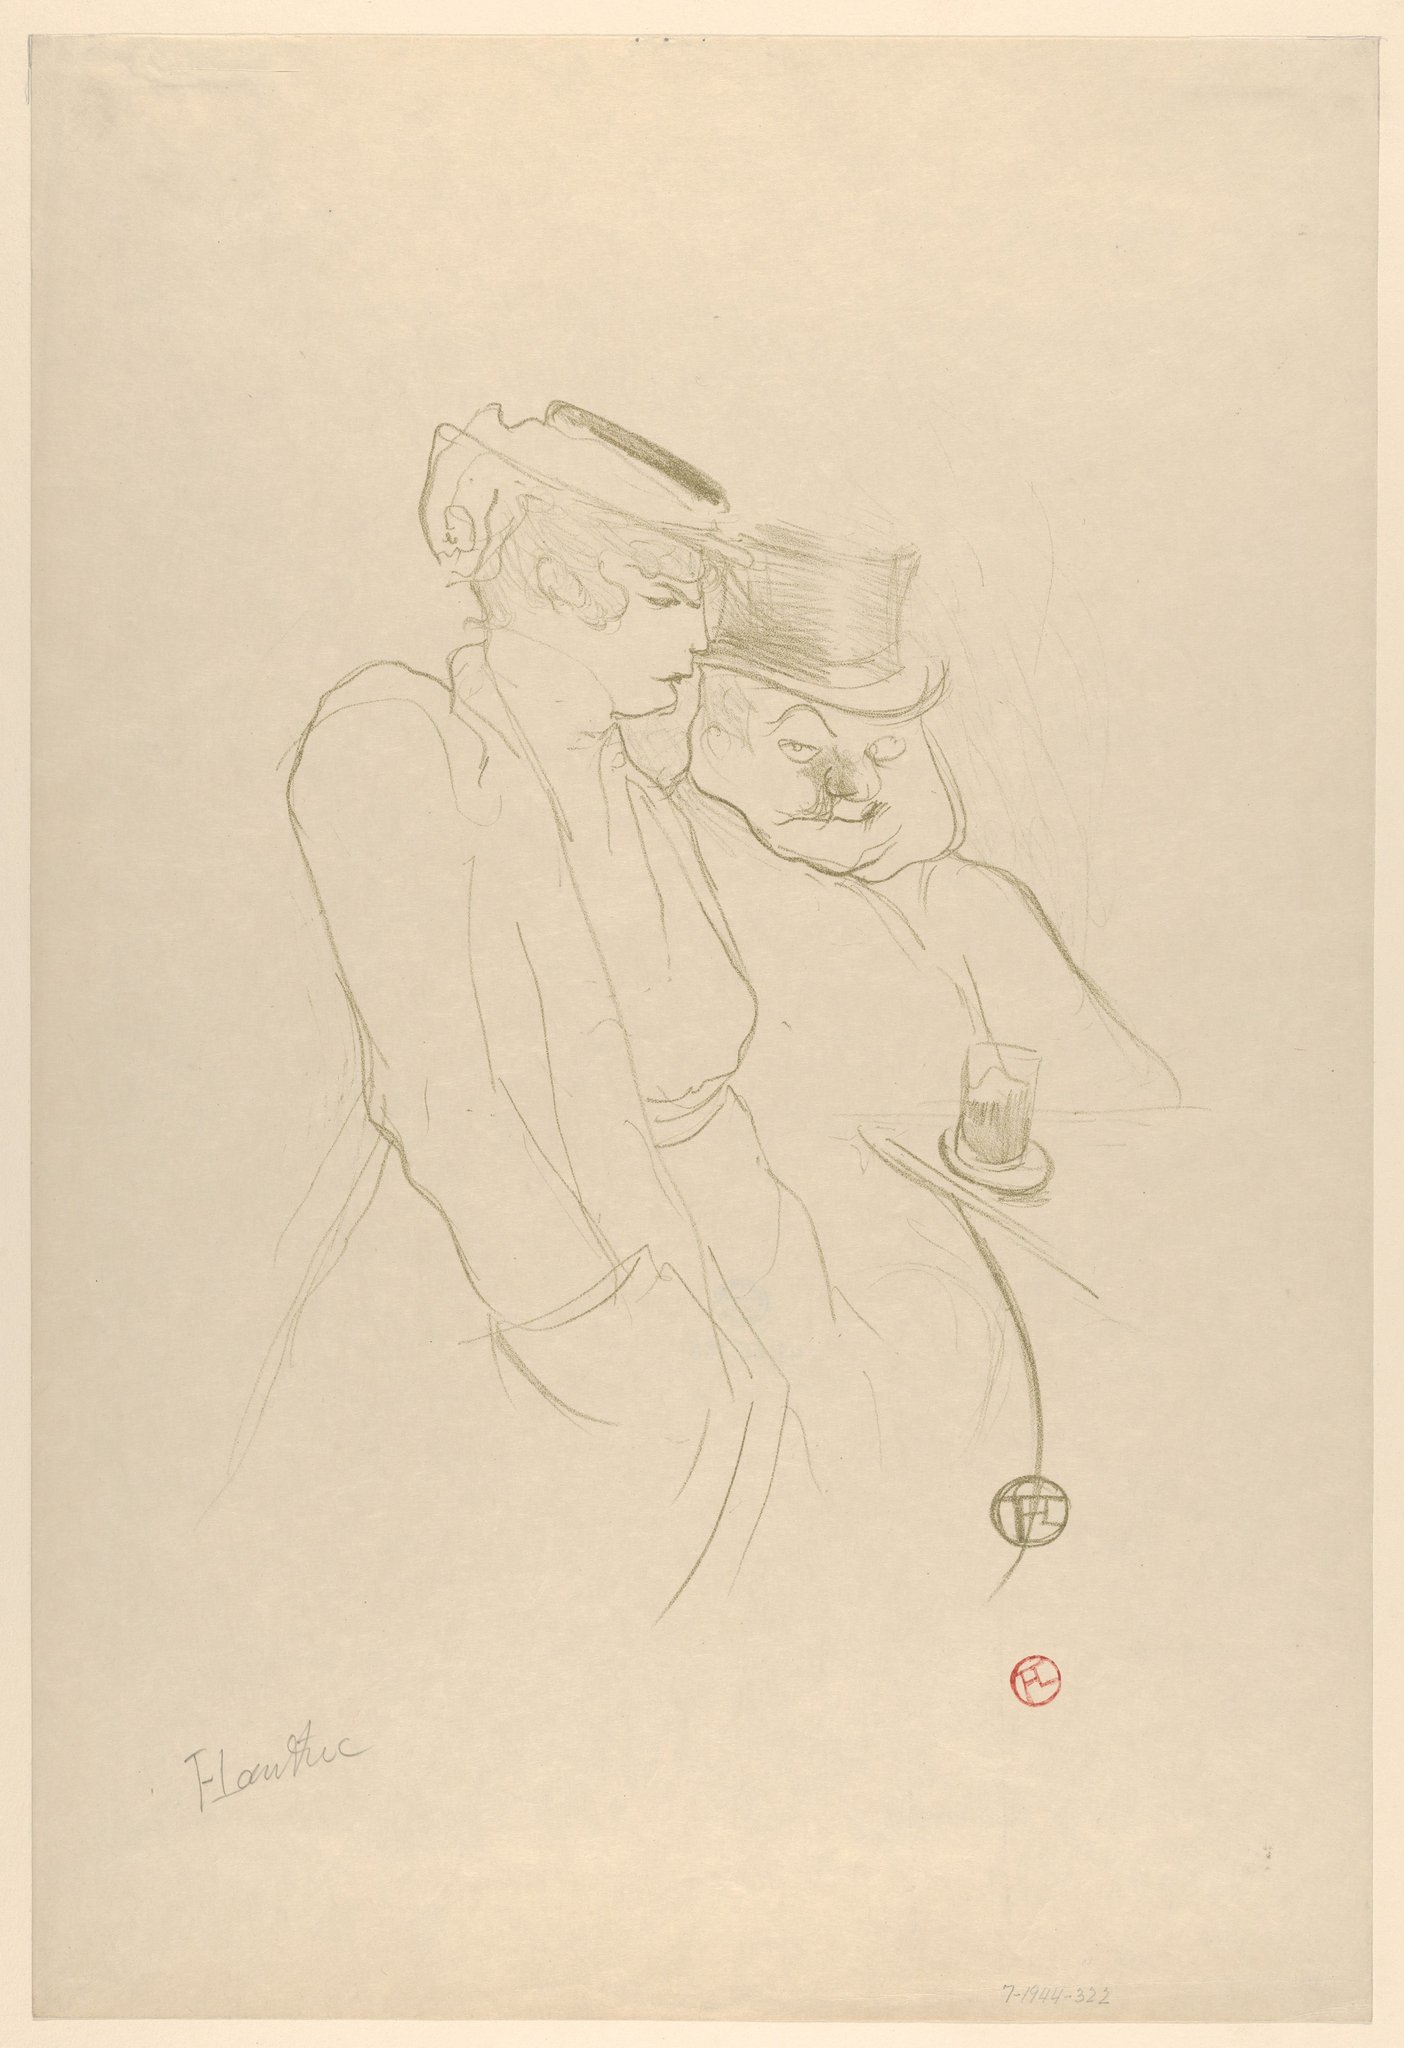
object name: print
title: In Their Forties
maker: henri de toulouse-lautrec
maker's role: artist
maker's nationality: french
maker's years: 1864-1901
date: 1893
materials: crayon, paper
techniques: lithograph, printing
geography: france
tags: men,women